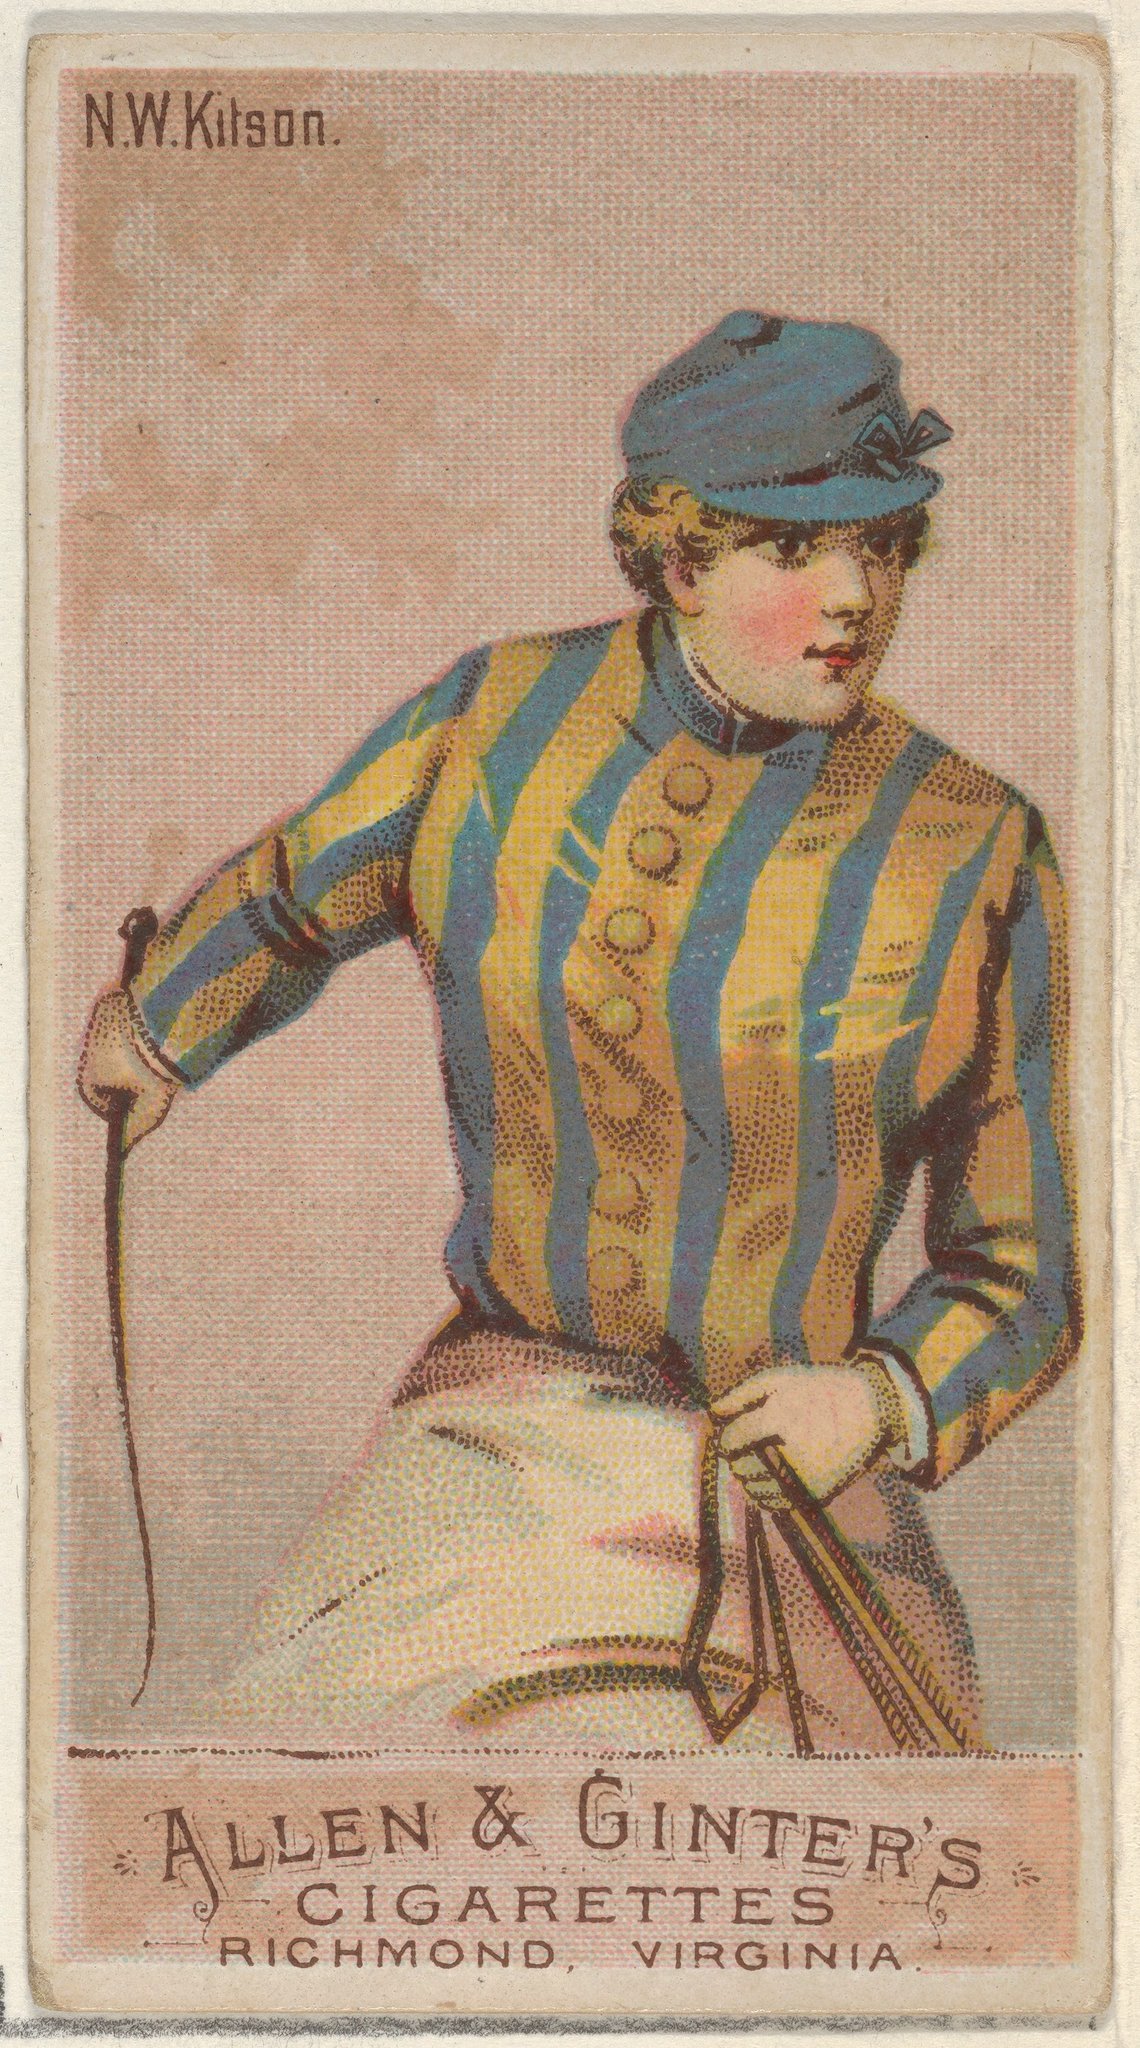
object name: print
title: N.W. Kitson, from the Racing Colors of the World series (N22a) for Allen & Ginter Cigarettes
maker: allen & ginter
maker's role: publisher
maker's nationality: american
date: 1888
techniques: color lithograph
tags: women,jockeys